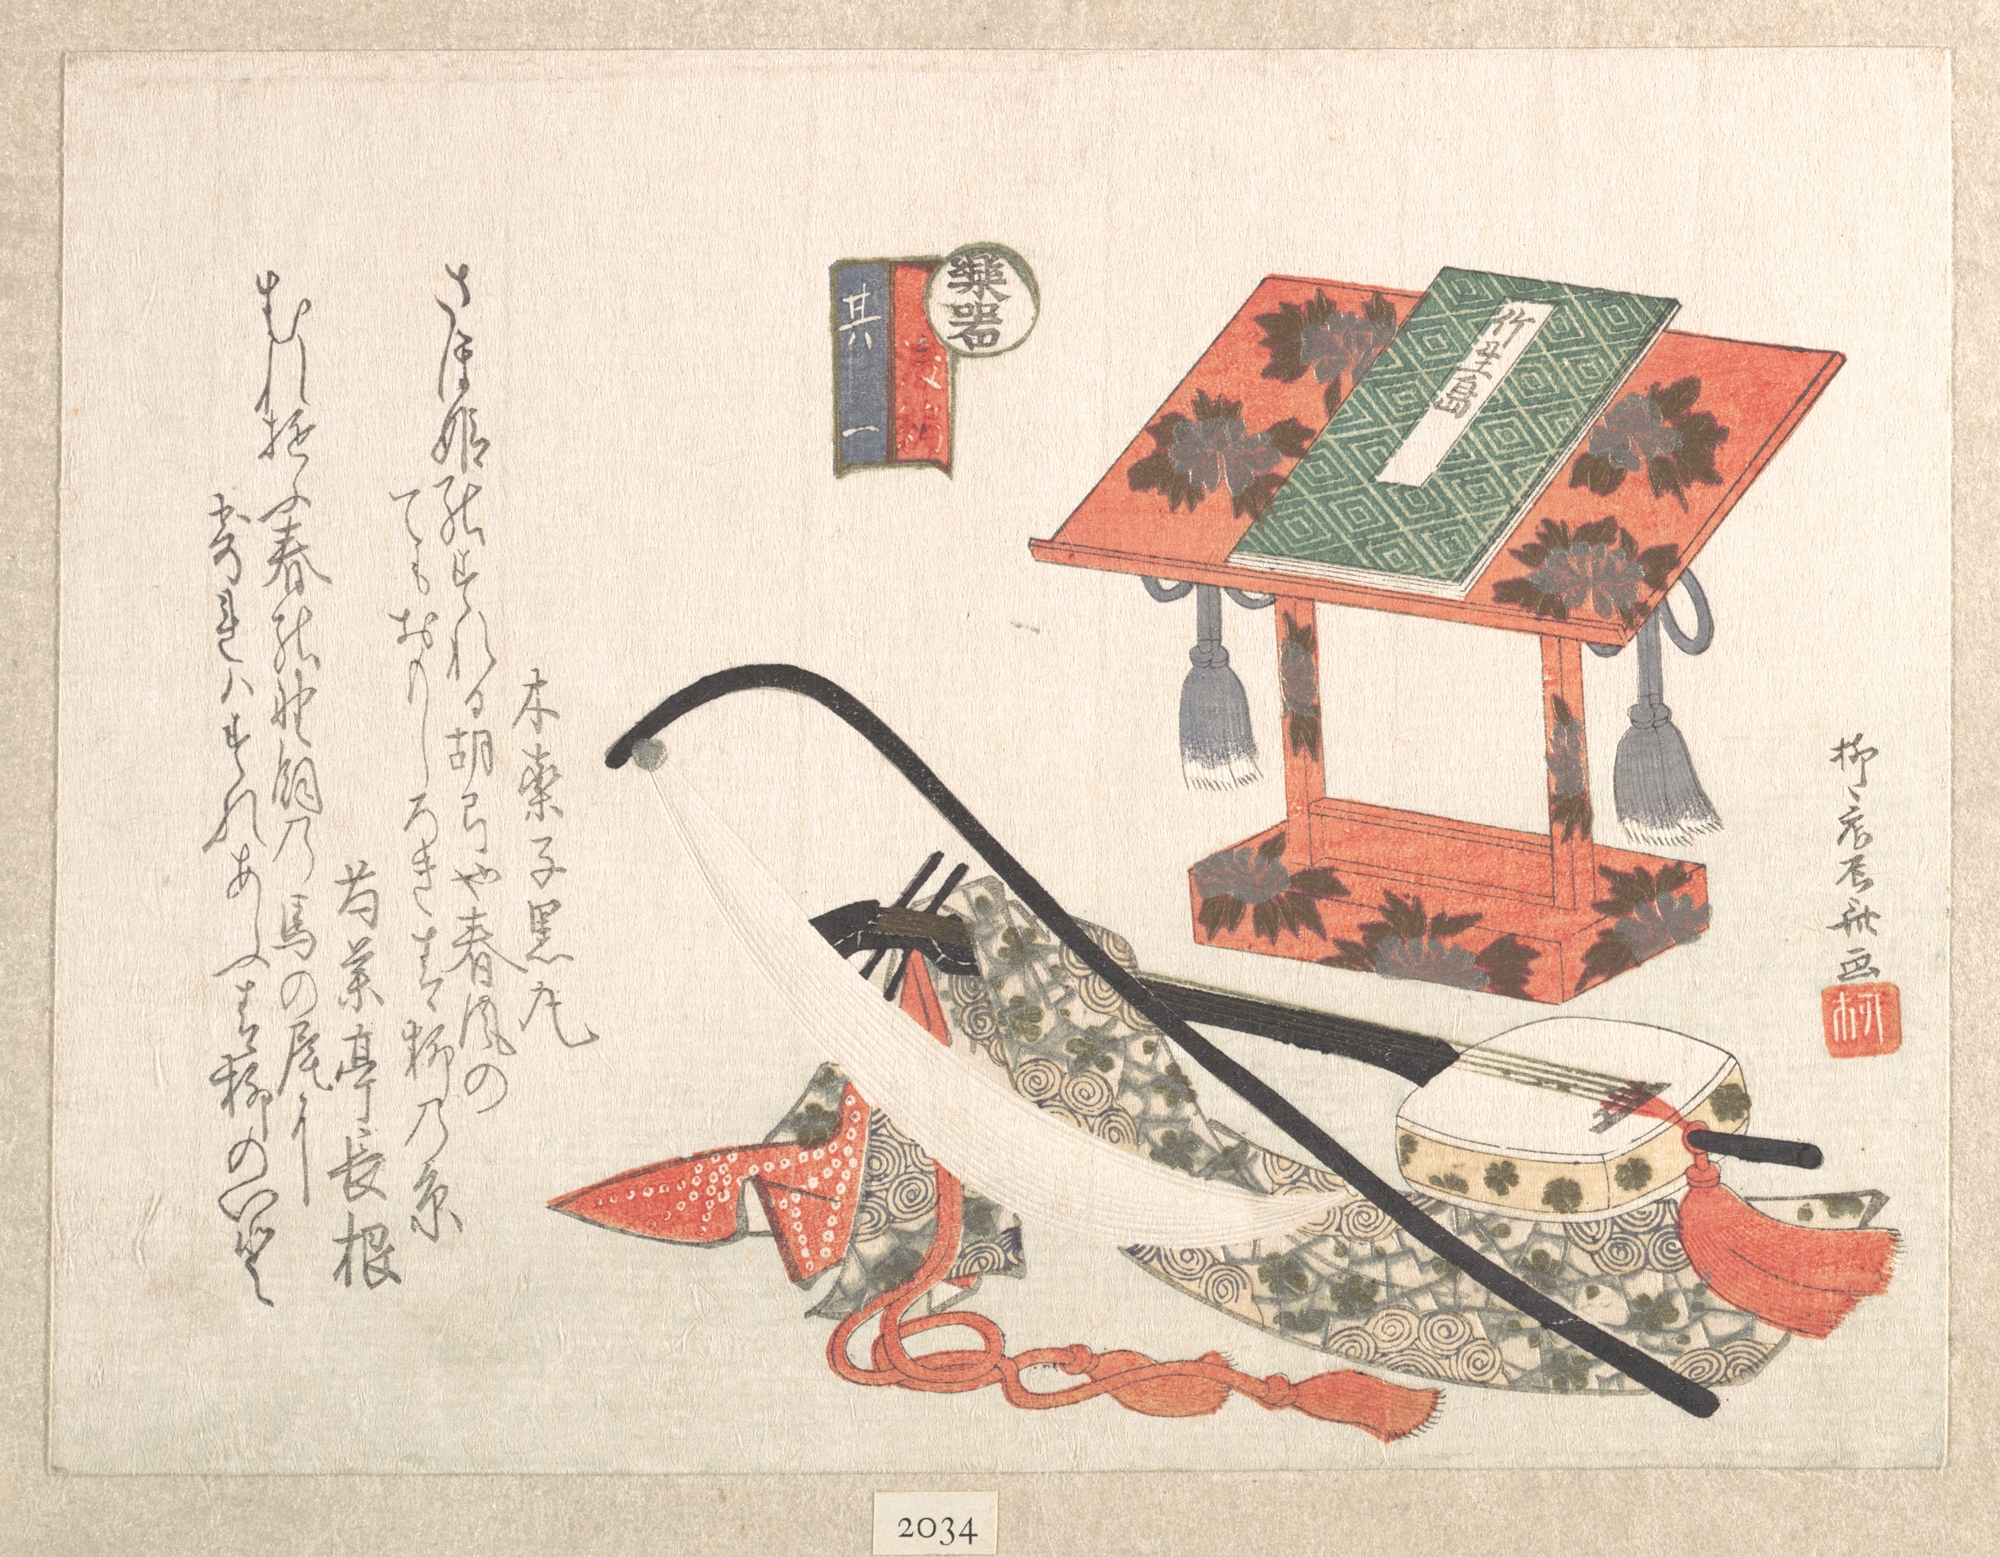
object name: print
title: Instruments and Stand for Music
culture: japanese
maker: ryūryūkyo shinsai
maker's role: artist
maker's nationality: japanese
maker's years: 1799-1823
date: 1801-1900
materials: ink, paper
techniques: surimono, woodblock print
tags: musical instruments